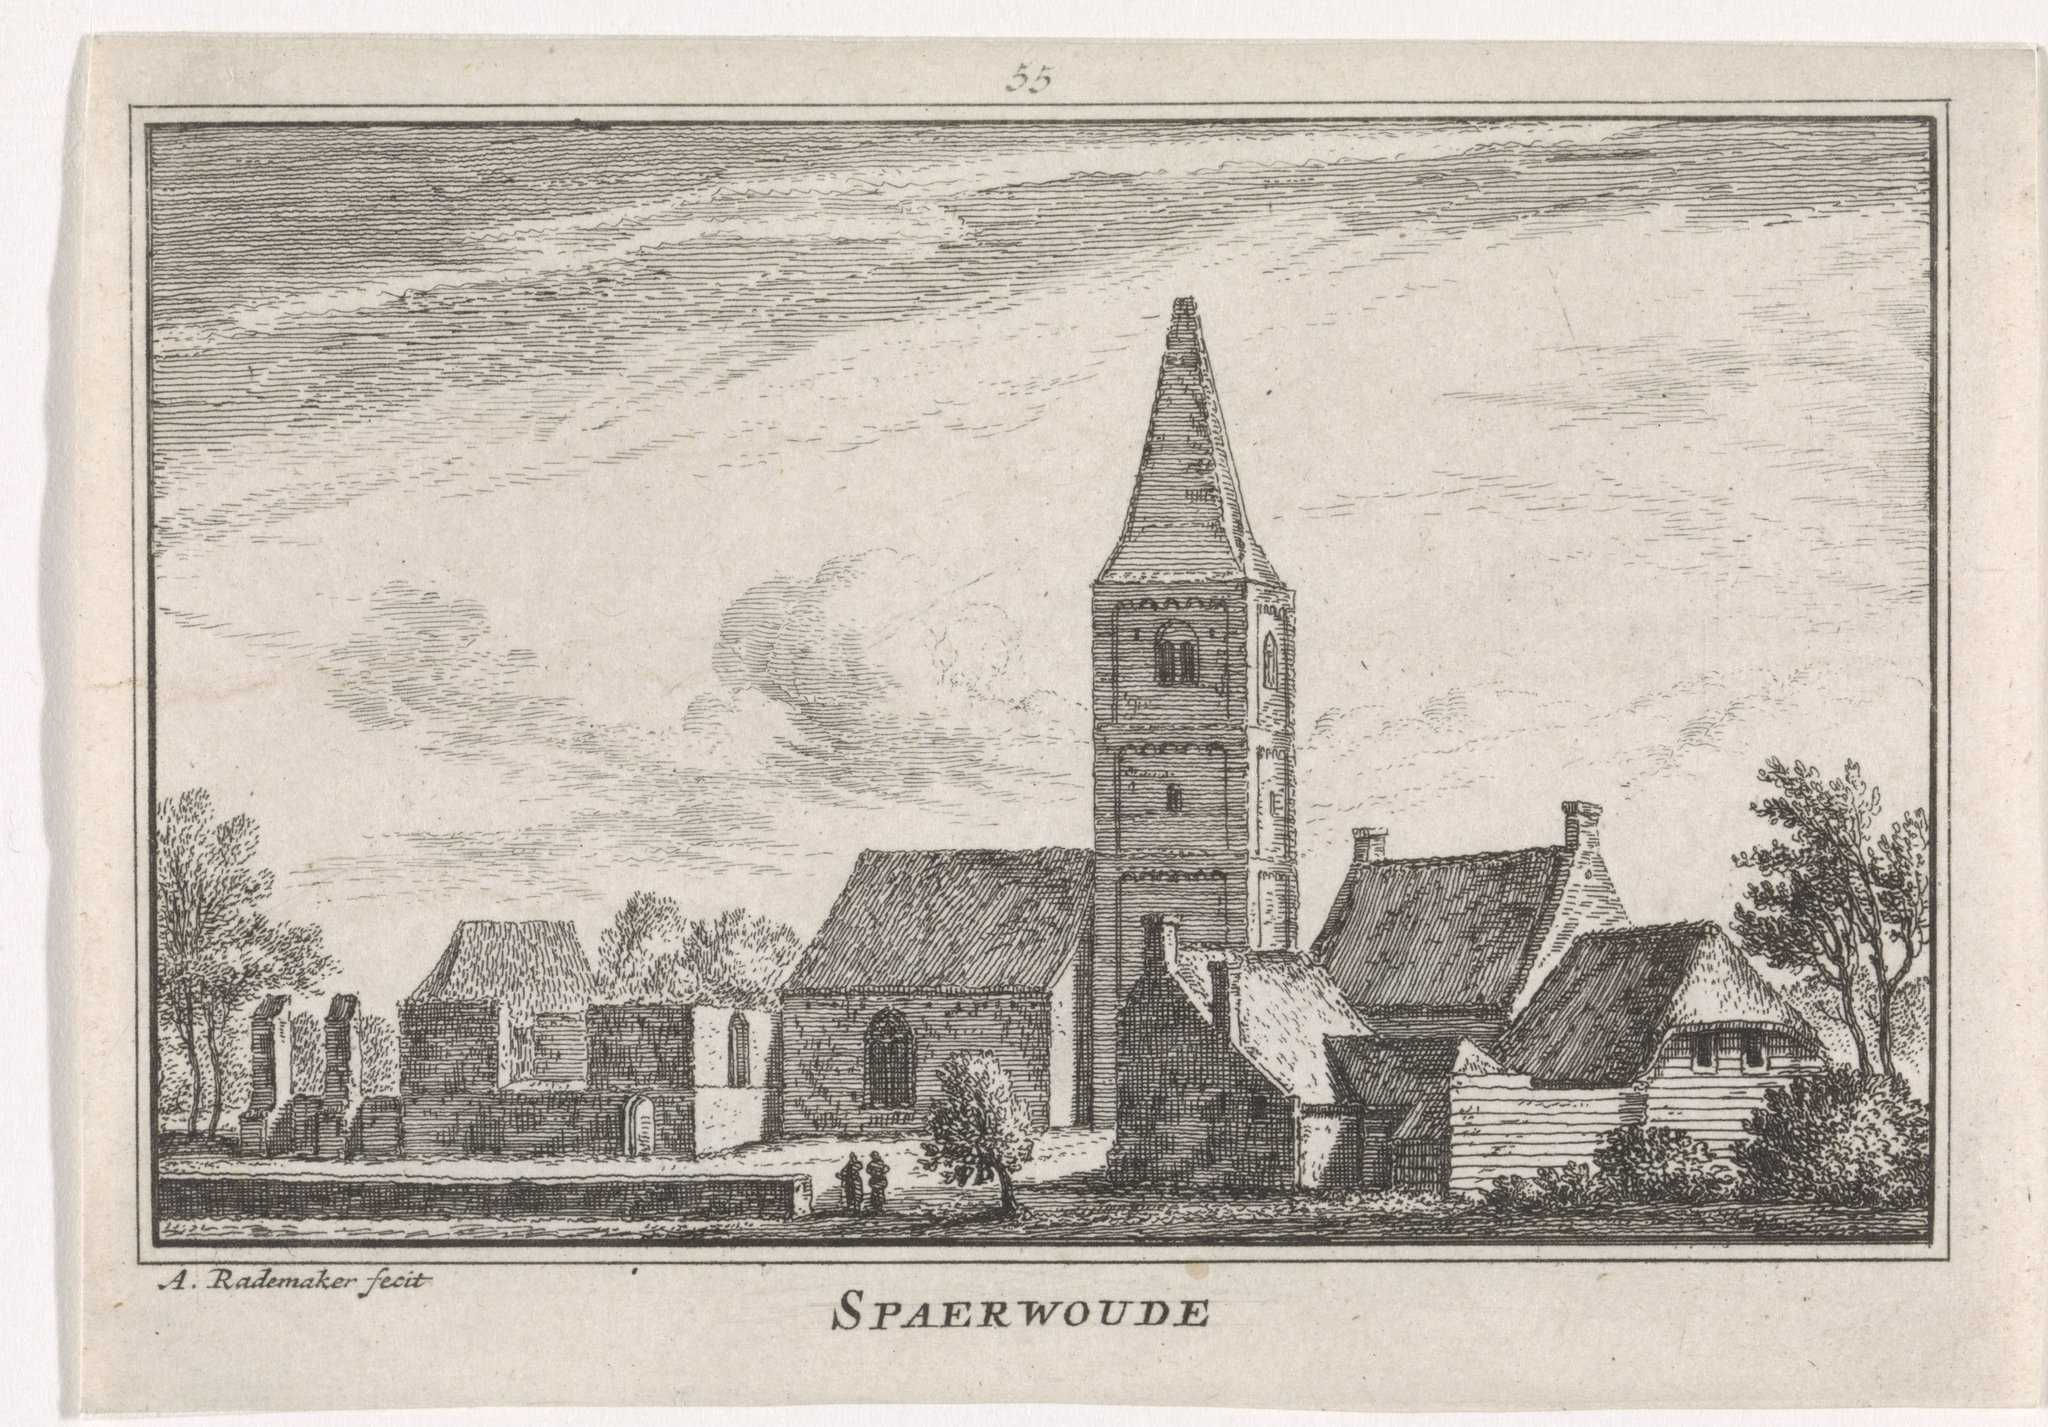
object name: print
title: Gezicht op de kerk te Spaarnwoude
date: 1727-1733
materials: paper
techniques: etching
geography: amsterdam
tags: church (exterior)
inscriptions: collector's mark: Lugt 2228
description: Illustratie uit: Abraham Rademaker, Matthaeus Brouërius van Niedek, Isaac Le Long, Kabinet van Nederlandsche en Kleefsche outheden en (...) voorname stads- en landgebouwen, Willem Barents en Antoni Schoonenburg: Amsterdam, 1727-1733, ill. nr. 55.